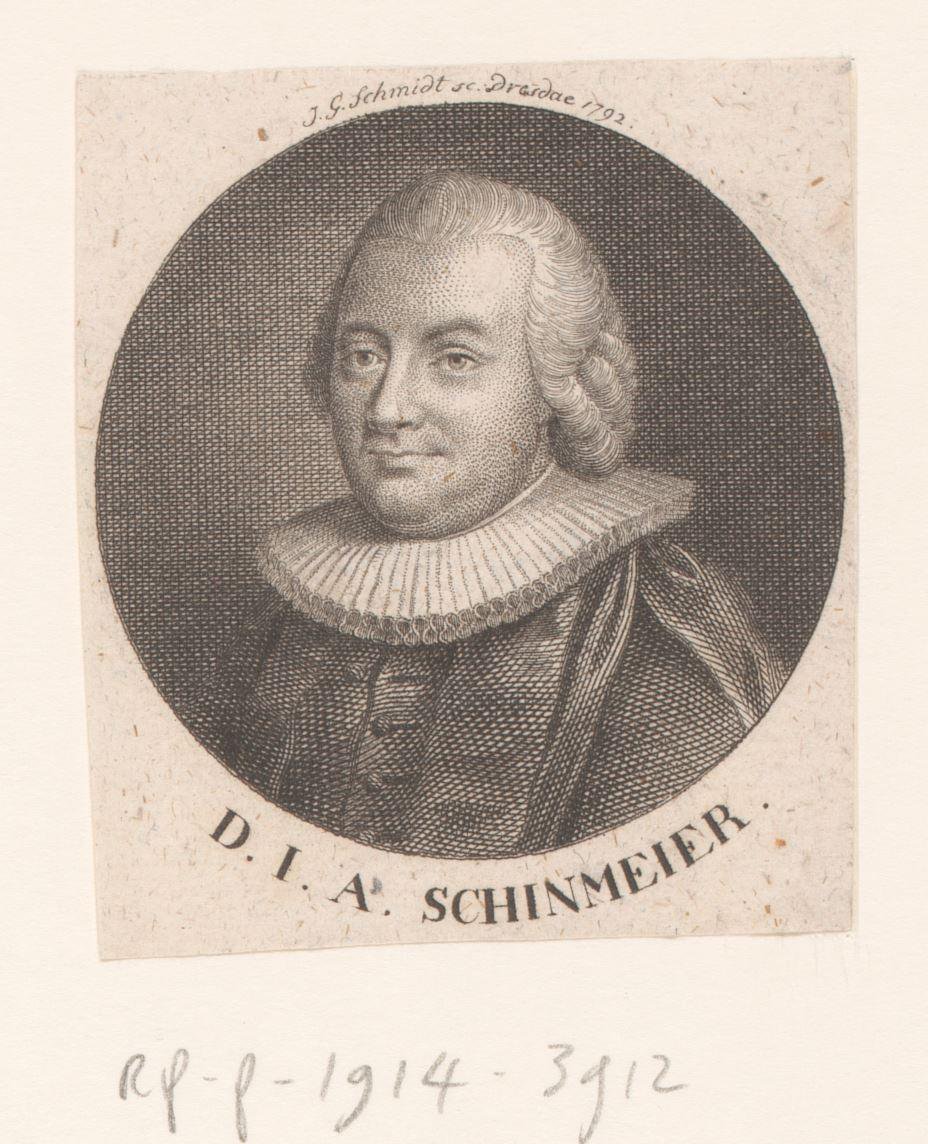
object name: print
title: Portret van Johann Adolf Schinmeyer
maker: johann gottfried schmidt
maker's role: print maker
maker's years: 1764-1803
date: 1792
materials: paper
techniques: engraving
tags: historical persons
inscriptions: collector's mark: Lugt 2228